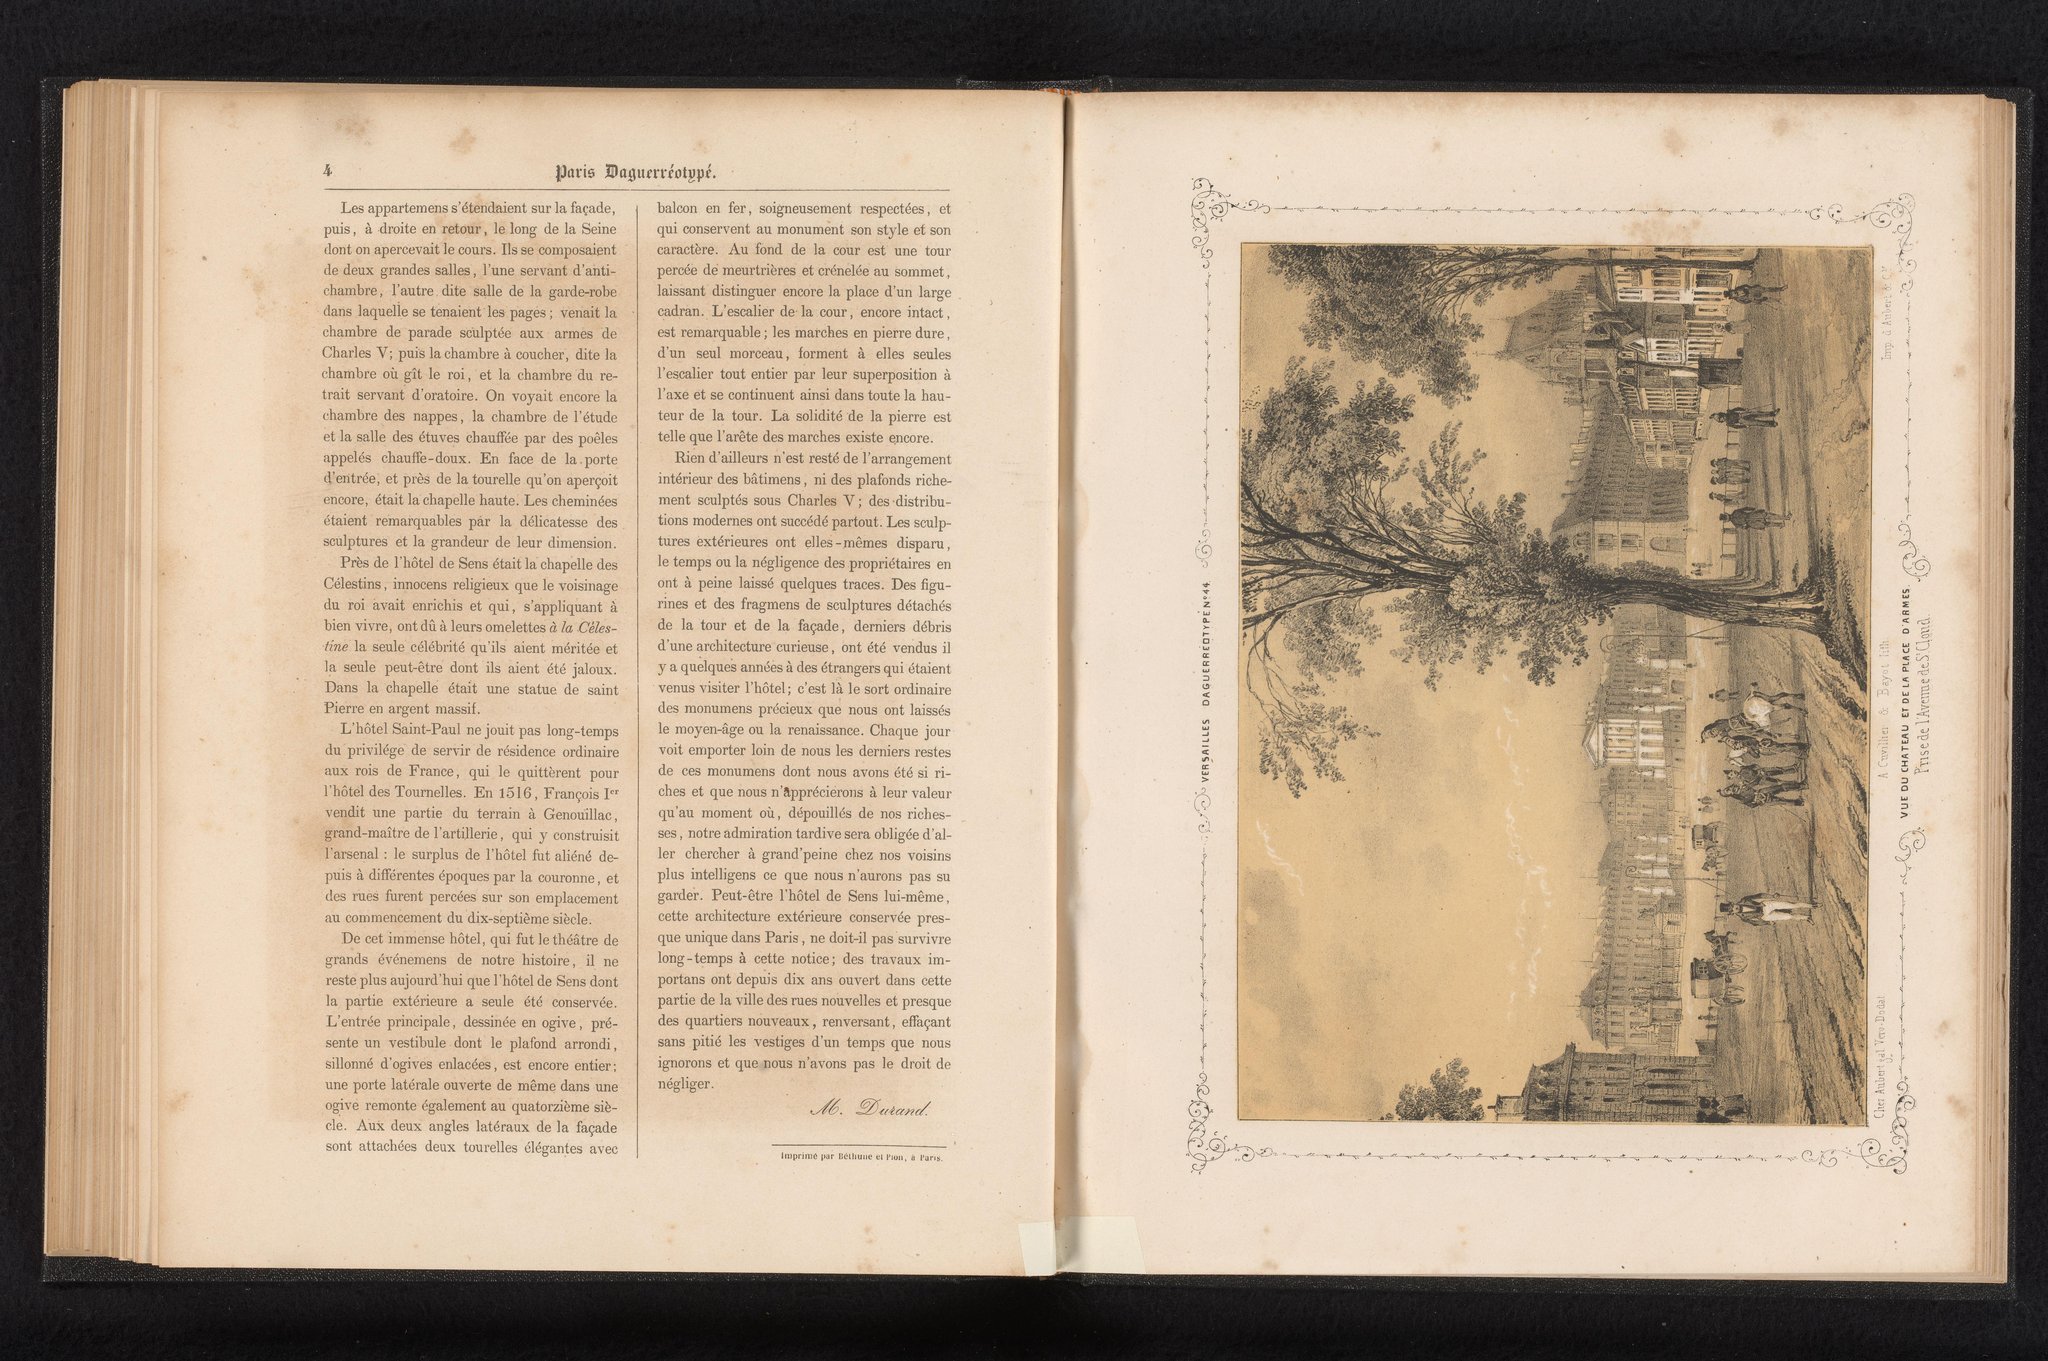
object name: page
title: Vue du chateau et de la Place d'Armes, prise de l'Avenue de S. Cloud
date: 1839-1840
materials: paper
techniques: tone lithography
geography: paris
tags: square, place, circus, etc.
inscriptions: inscription: ‘VERSAILLES DAGUERRÉOTYPÉ No. 44.’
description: Prent op honderdvijfenzeventigste ongenummerde pagina.